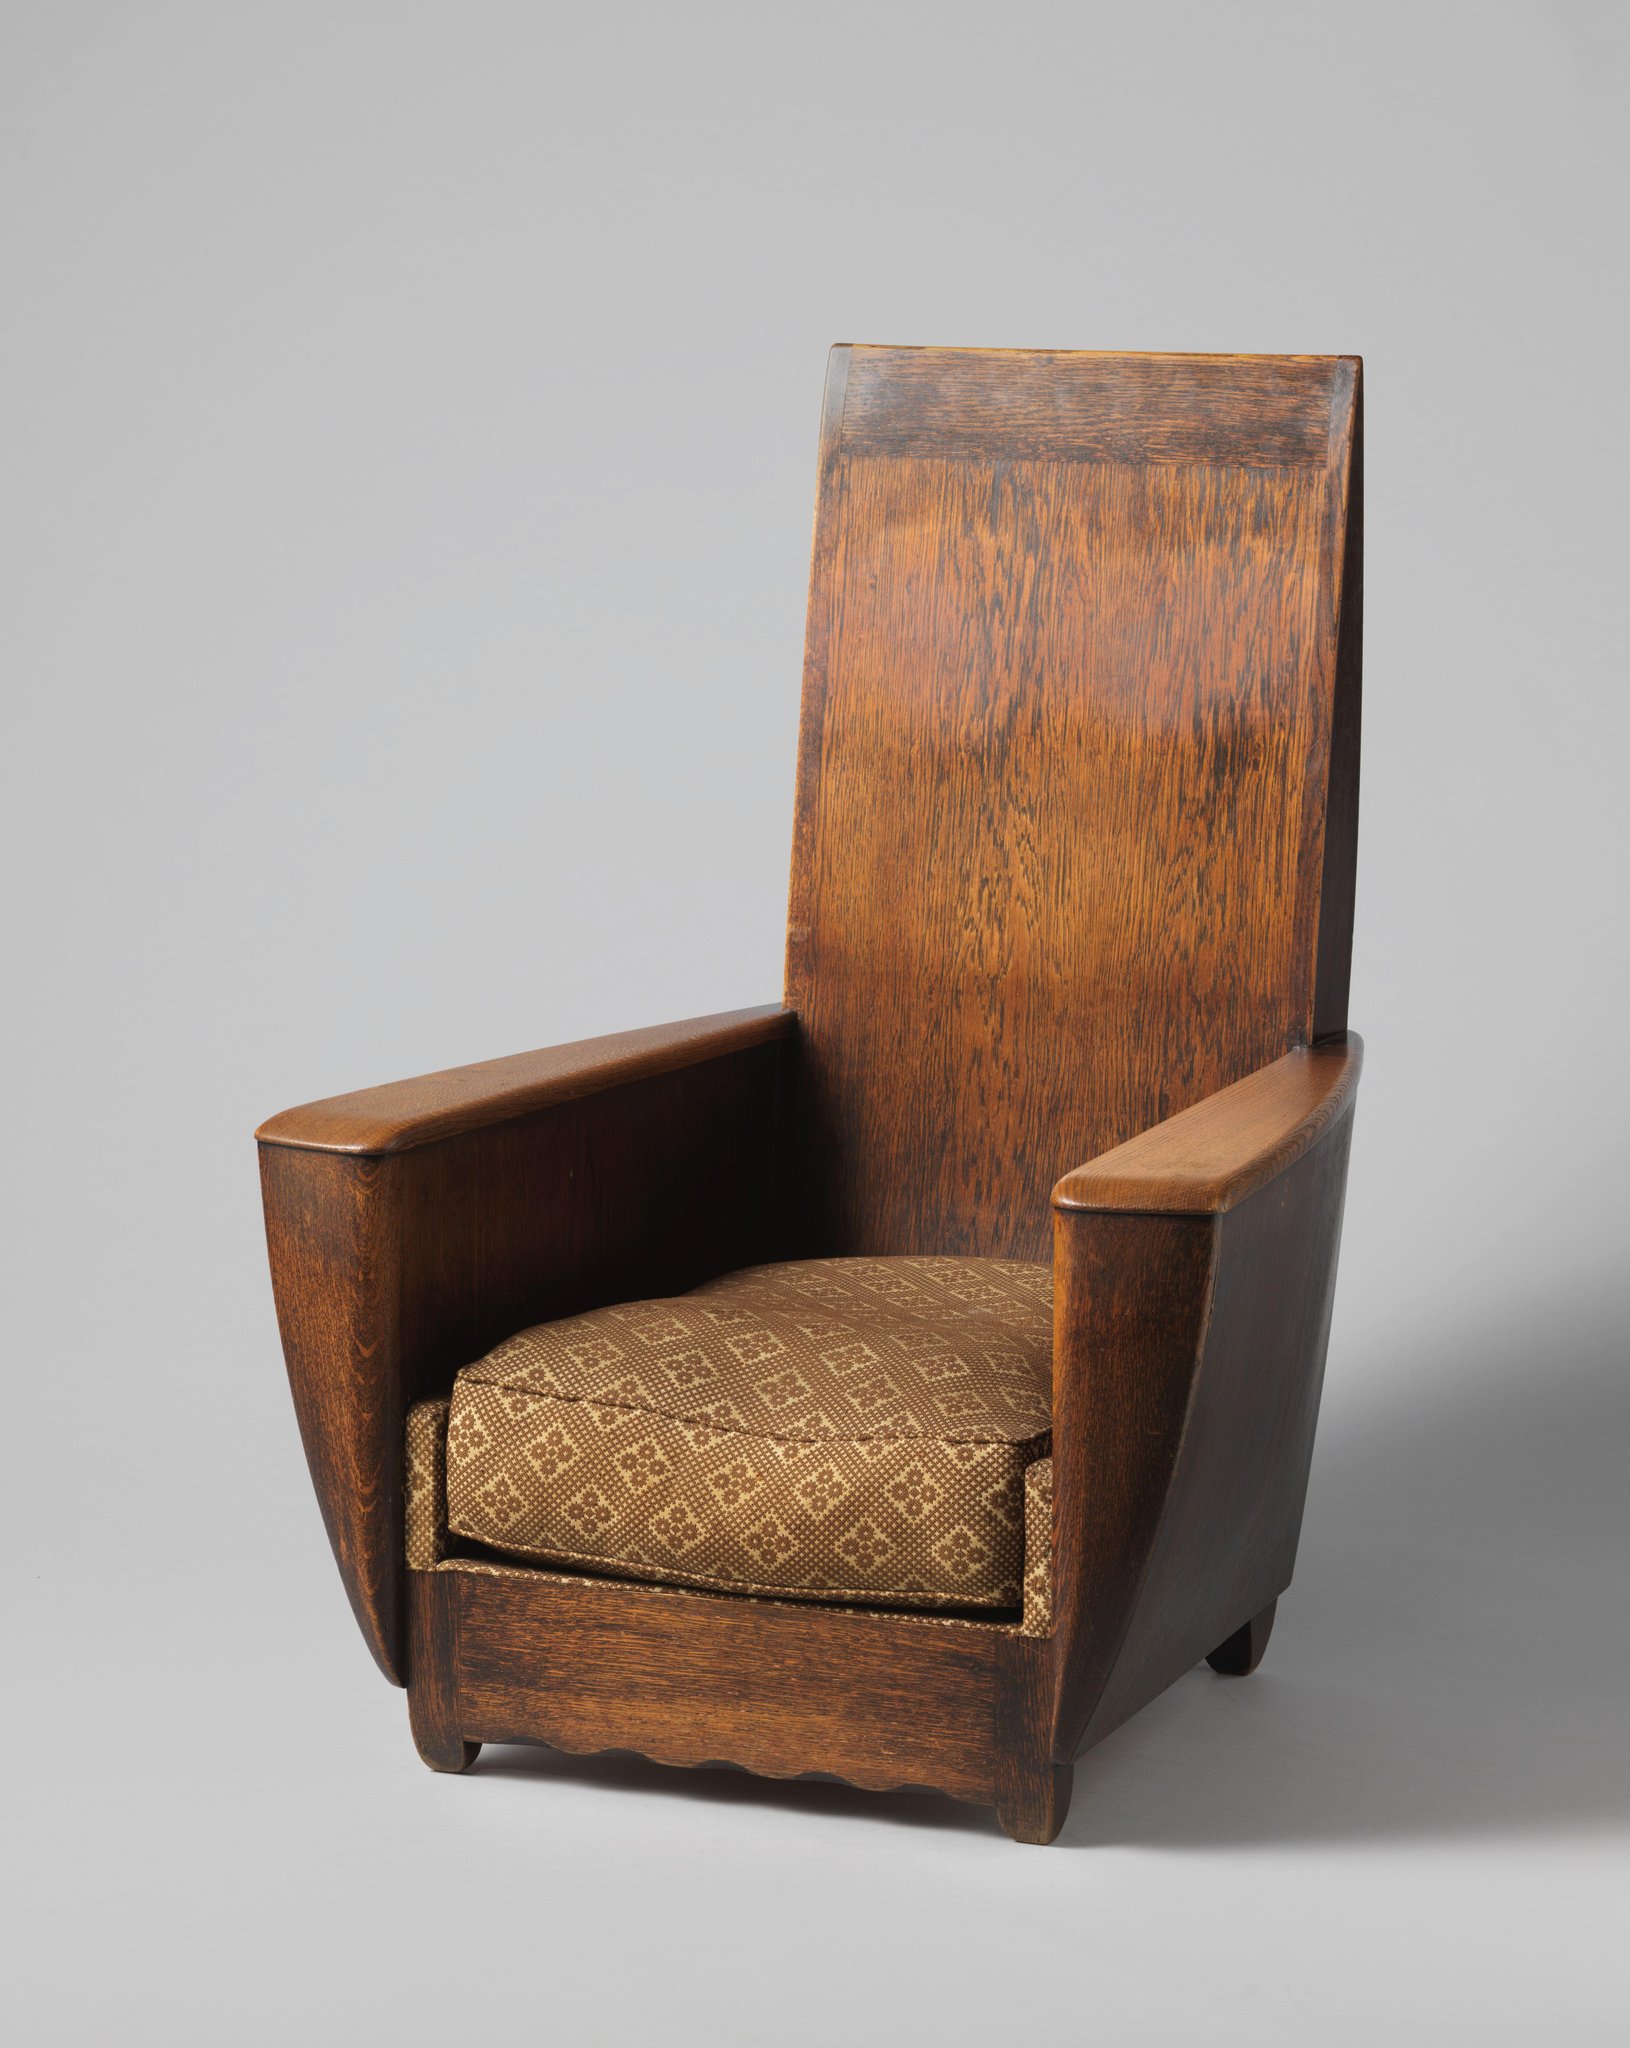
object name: seating furniture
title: Fauteuil met hoog opgetrokken rugleuning en bekleed met een beige stof met een bruin ruitmotief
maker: wim schuhmacher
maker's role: draughtsman, print maker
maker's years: 1894-1986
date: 1921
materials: wood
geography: netherlands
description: Fauteuil van donker getint eikenhout rustend op vier lage poten. De poten zijn zowel aan de voor- als achterzijde onderling verbonden door middel van een brede regel met een golvende rand aan de onderzijde. De fauteuil heeft brede wangen waarop de armleggers liggen. De armleggers verbreden naar de voorzijde. De aan de buitenzijde gebogen wangen verbreden naar de voor- en bovenzijde. De fauteuil heeft een hoog opgetrokken rugleuning. De zitting en een los kussen zijn bekleed met een beige stof met een bruin ruitmotief.